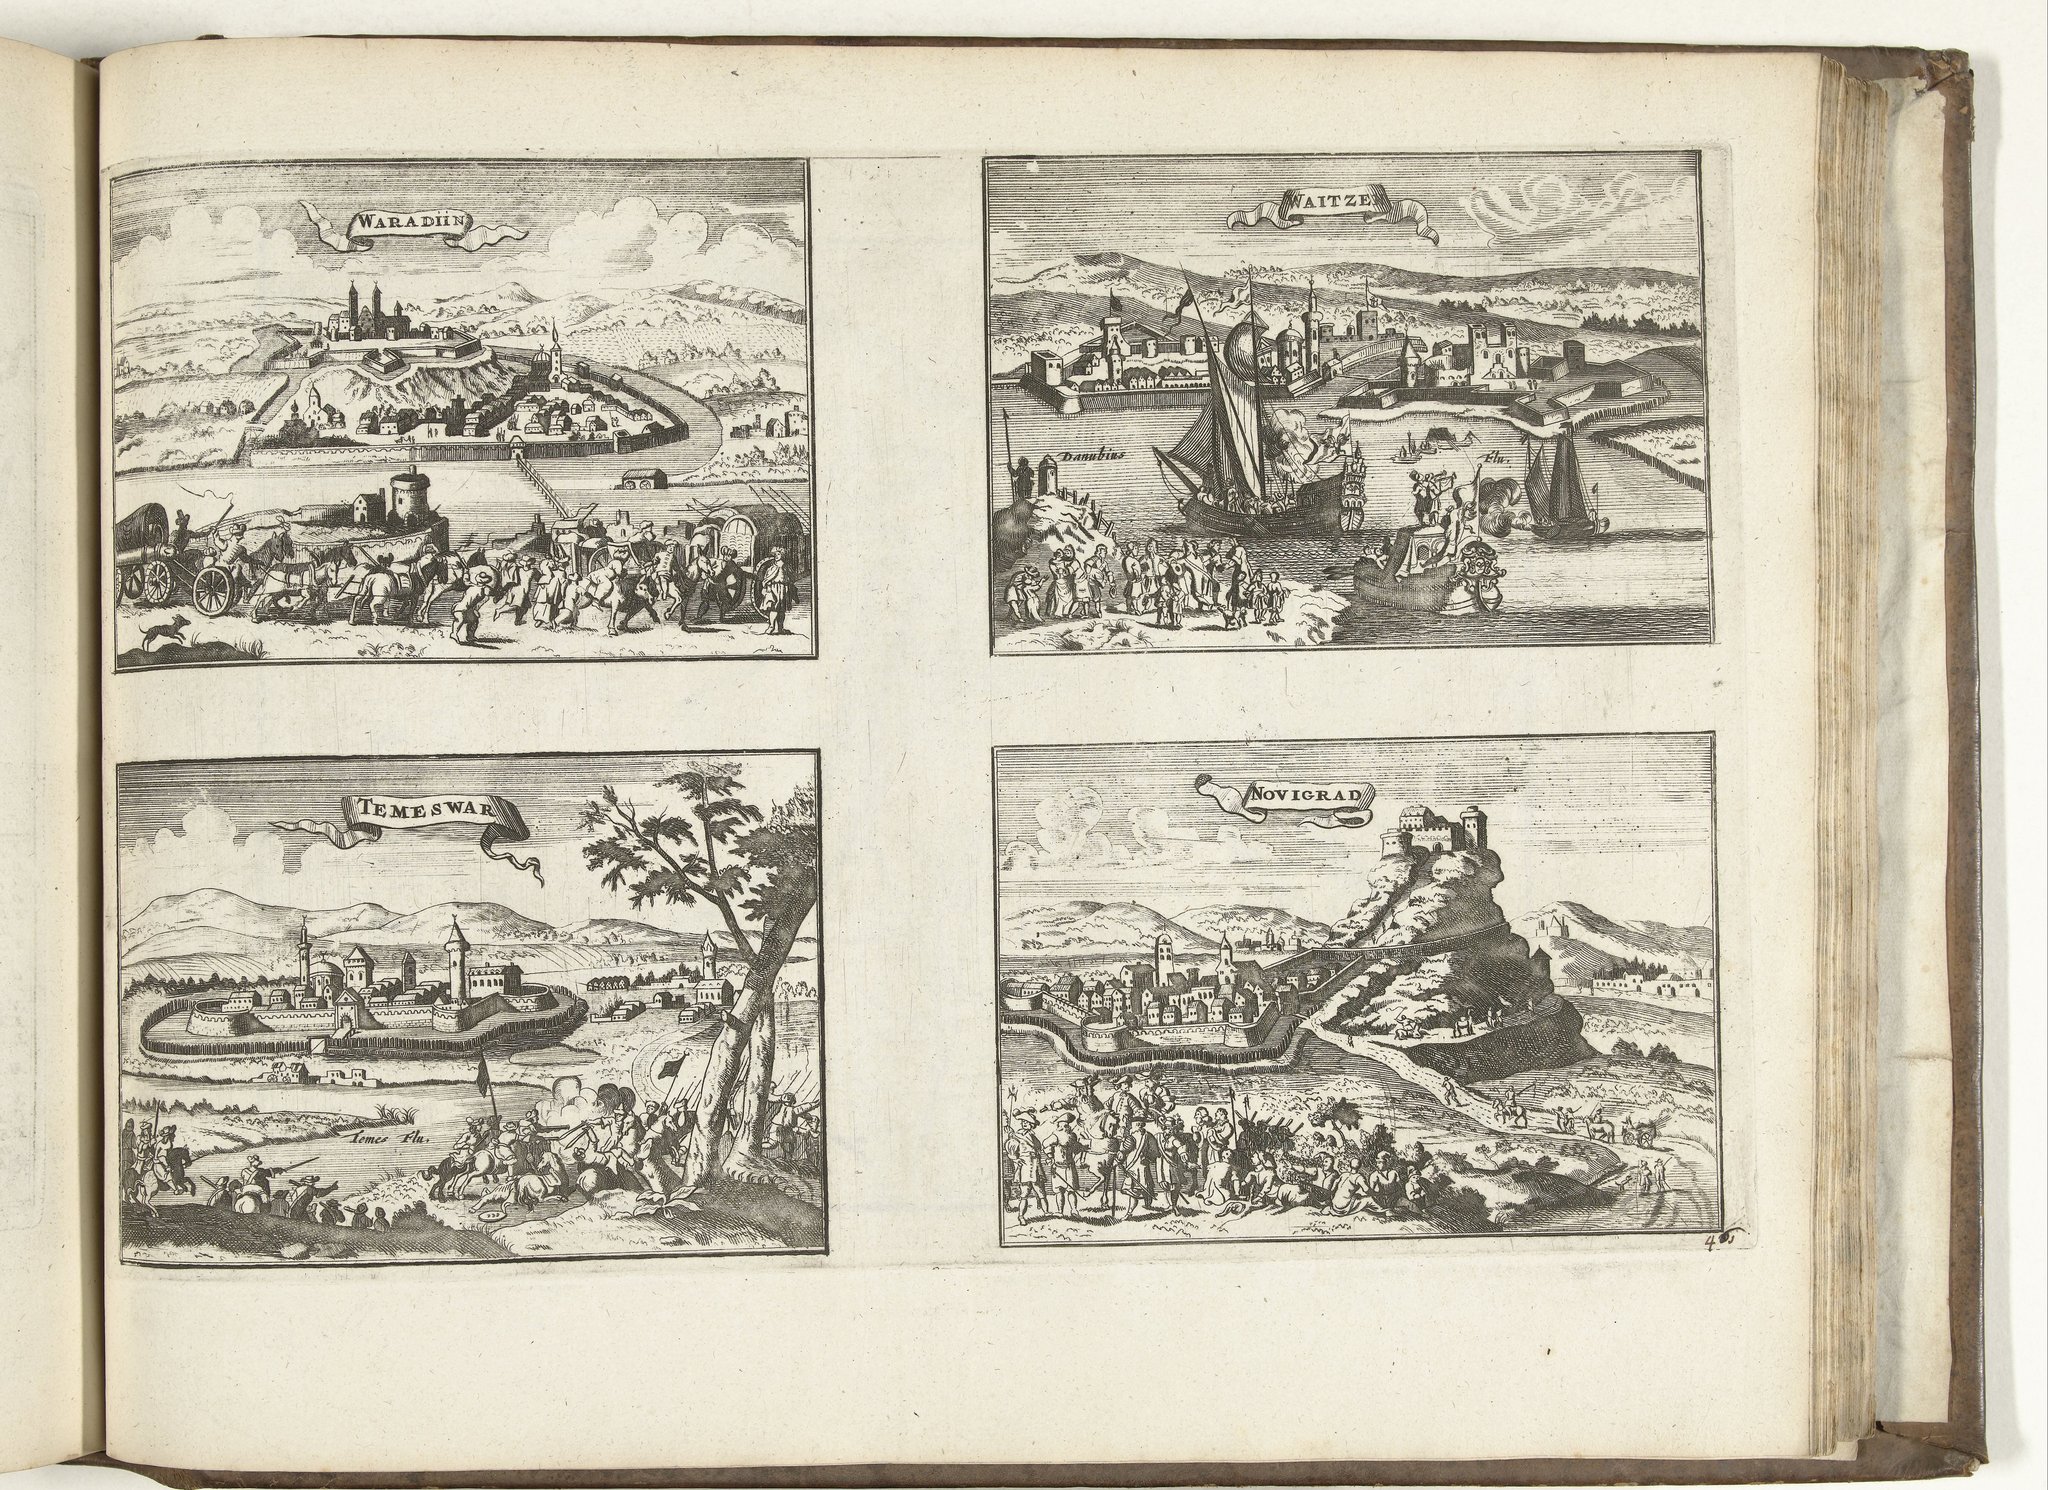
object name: print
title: Gezichten op Waradiin, Vác, Temesvár en Novigrad, 1726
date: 1726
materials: paper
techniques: etching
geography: northern netherlands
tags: vác, novigrad, timisoara, spaanse successieoorlog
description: Blad met vier gezichten op Oost-Europese steden Waradiin, Vác, Temesvár en Novigrad. Plaat nr. 461 in deel XVIII van het prentwerk: Les Forces de l'Europe, Asie, Afrique et Amerique ... Comme aussi les Cartes des Côtes de France et d'Espagne uit 1726, dit tweede deel met 271 met de hand genummerde platen van vermaarde sterke steden en vestingen in het kader van de Spaanse Successieoorlog 1701-1713. Voor het merendeel zijn deze platen gekopieerd naar de anonieme Franse platen van vermaarde sterke steden en vestingen: in Les forces de l'Europe en in: Le theatre de la guerre, dans les Pays-Bas, beide oorspronkelijk uitgegeven door Nicolas de Fer te Parijs (1693-1697) in het kader van de Negenjarige Oorlog. Titels en opschriften in het Frans.